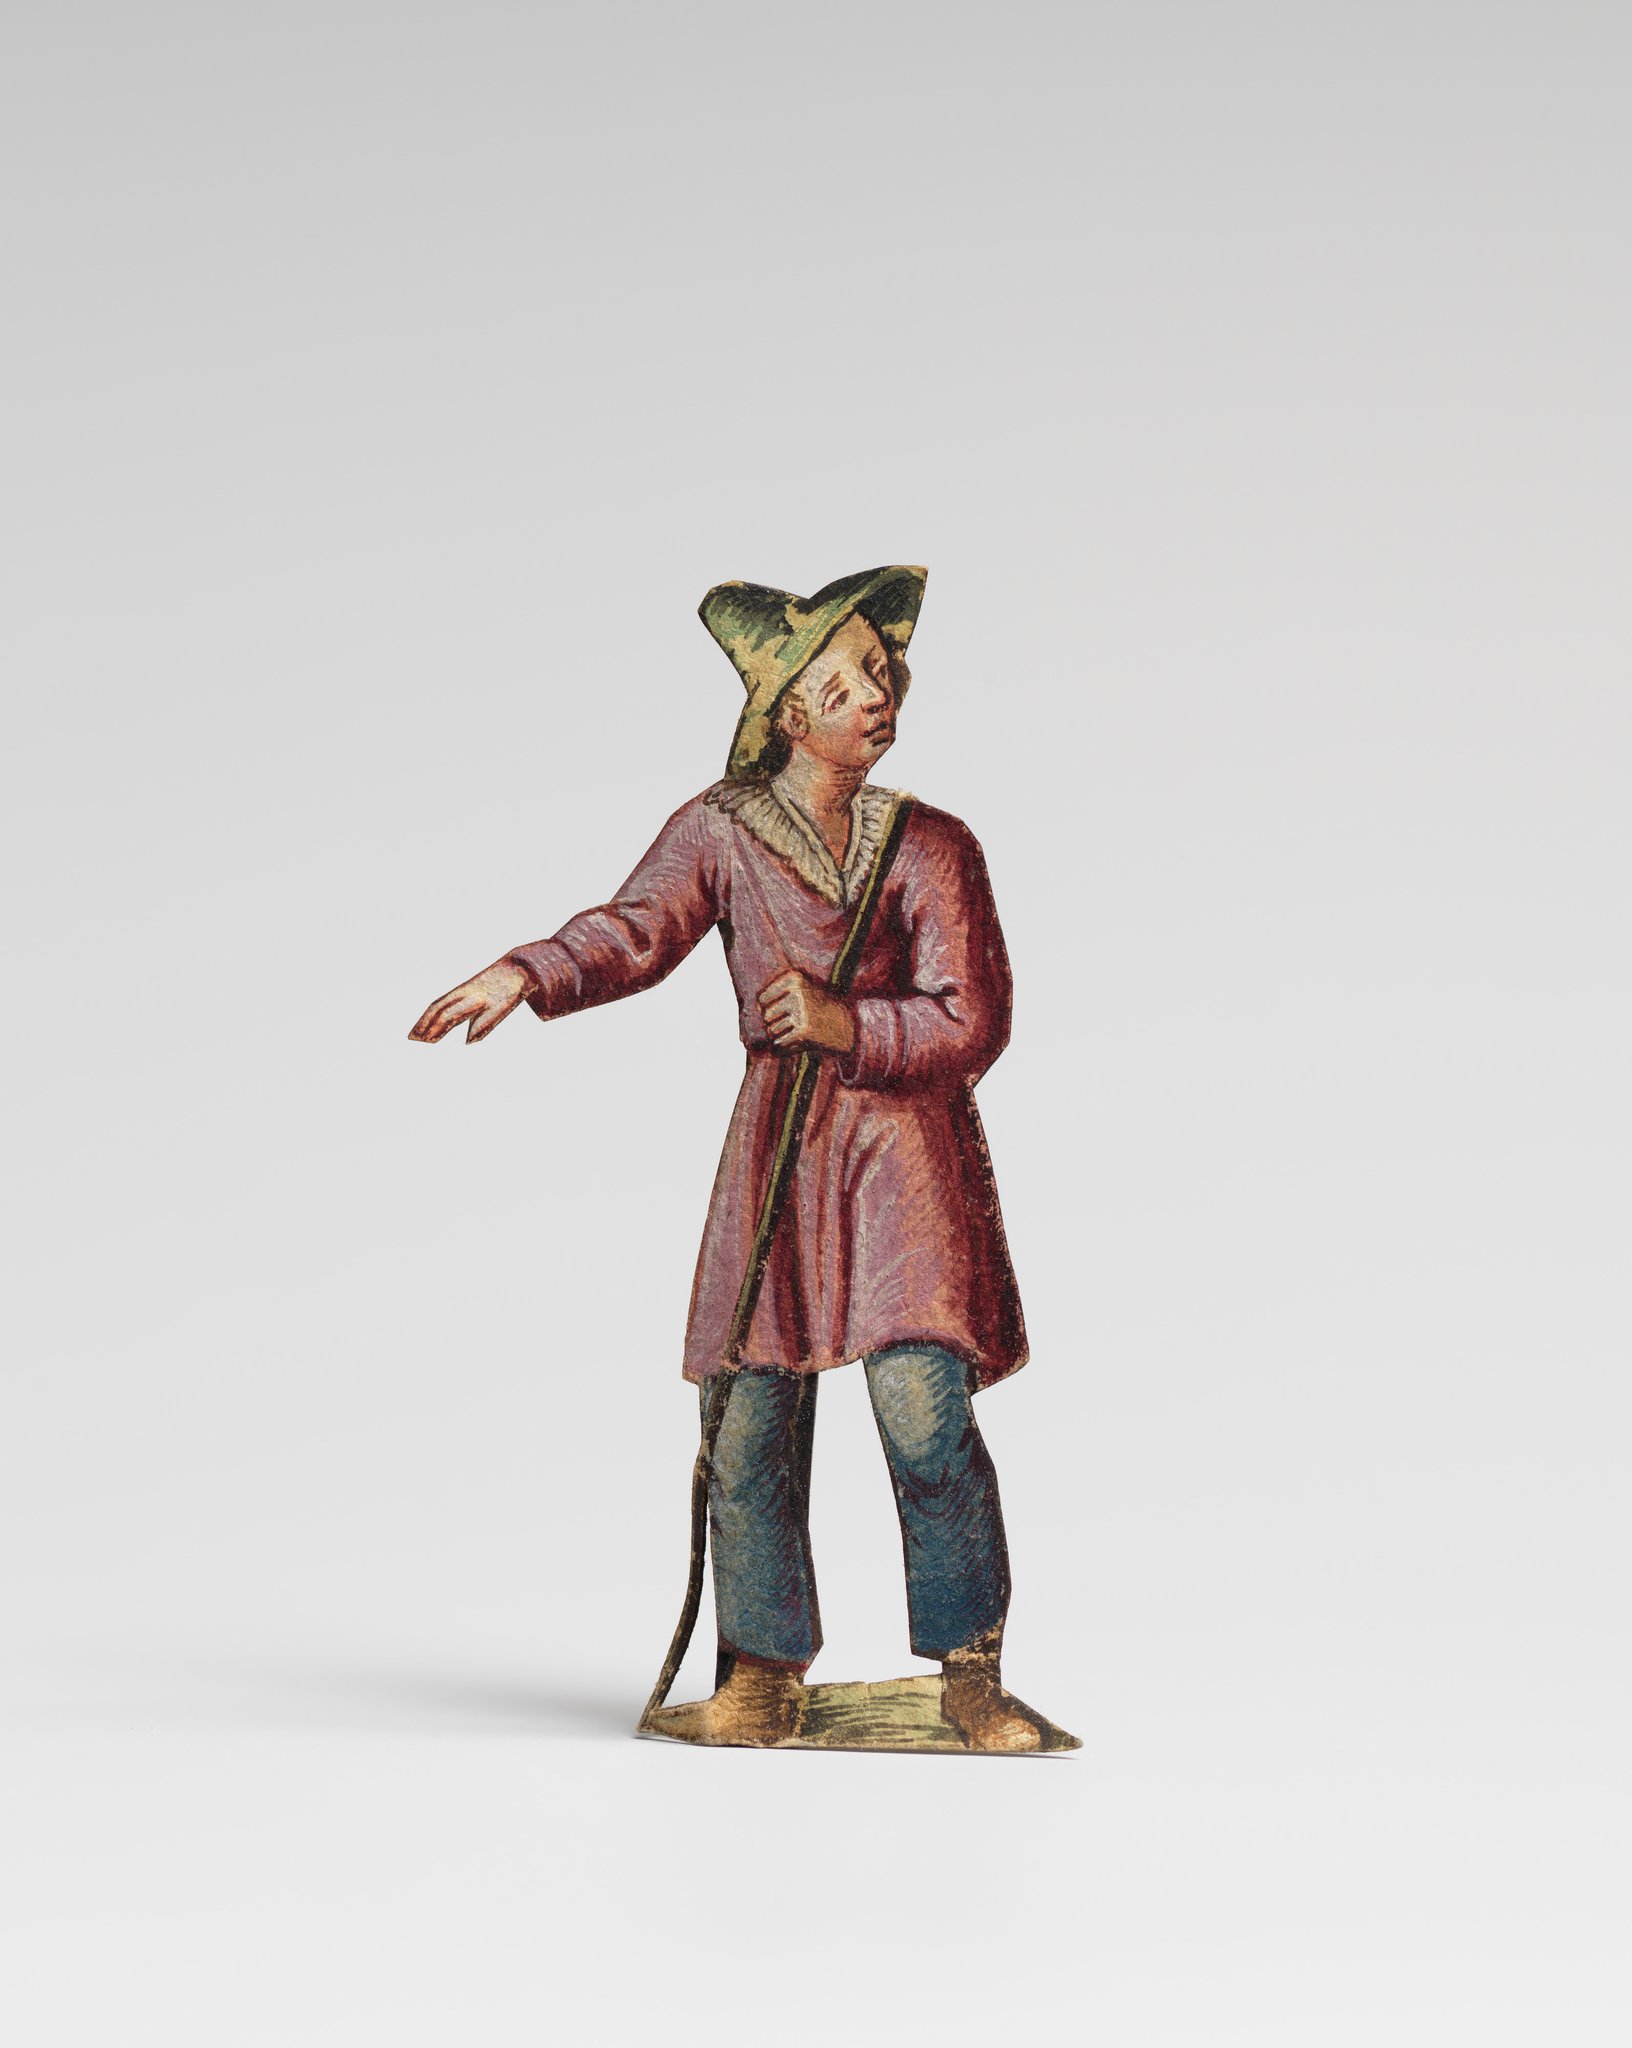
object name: figure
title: Shepherd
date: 1701-1800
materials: gouache, paper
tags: men,shepherds